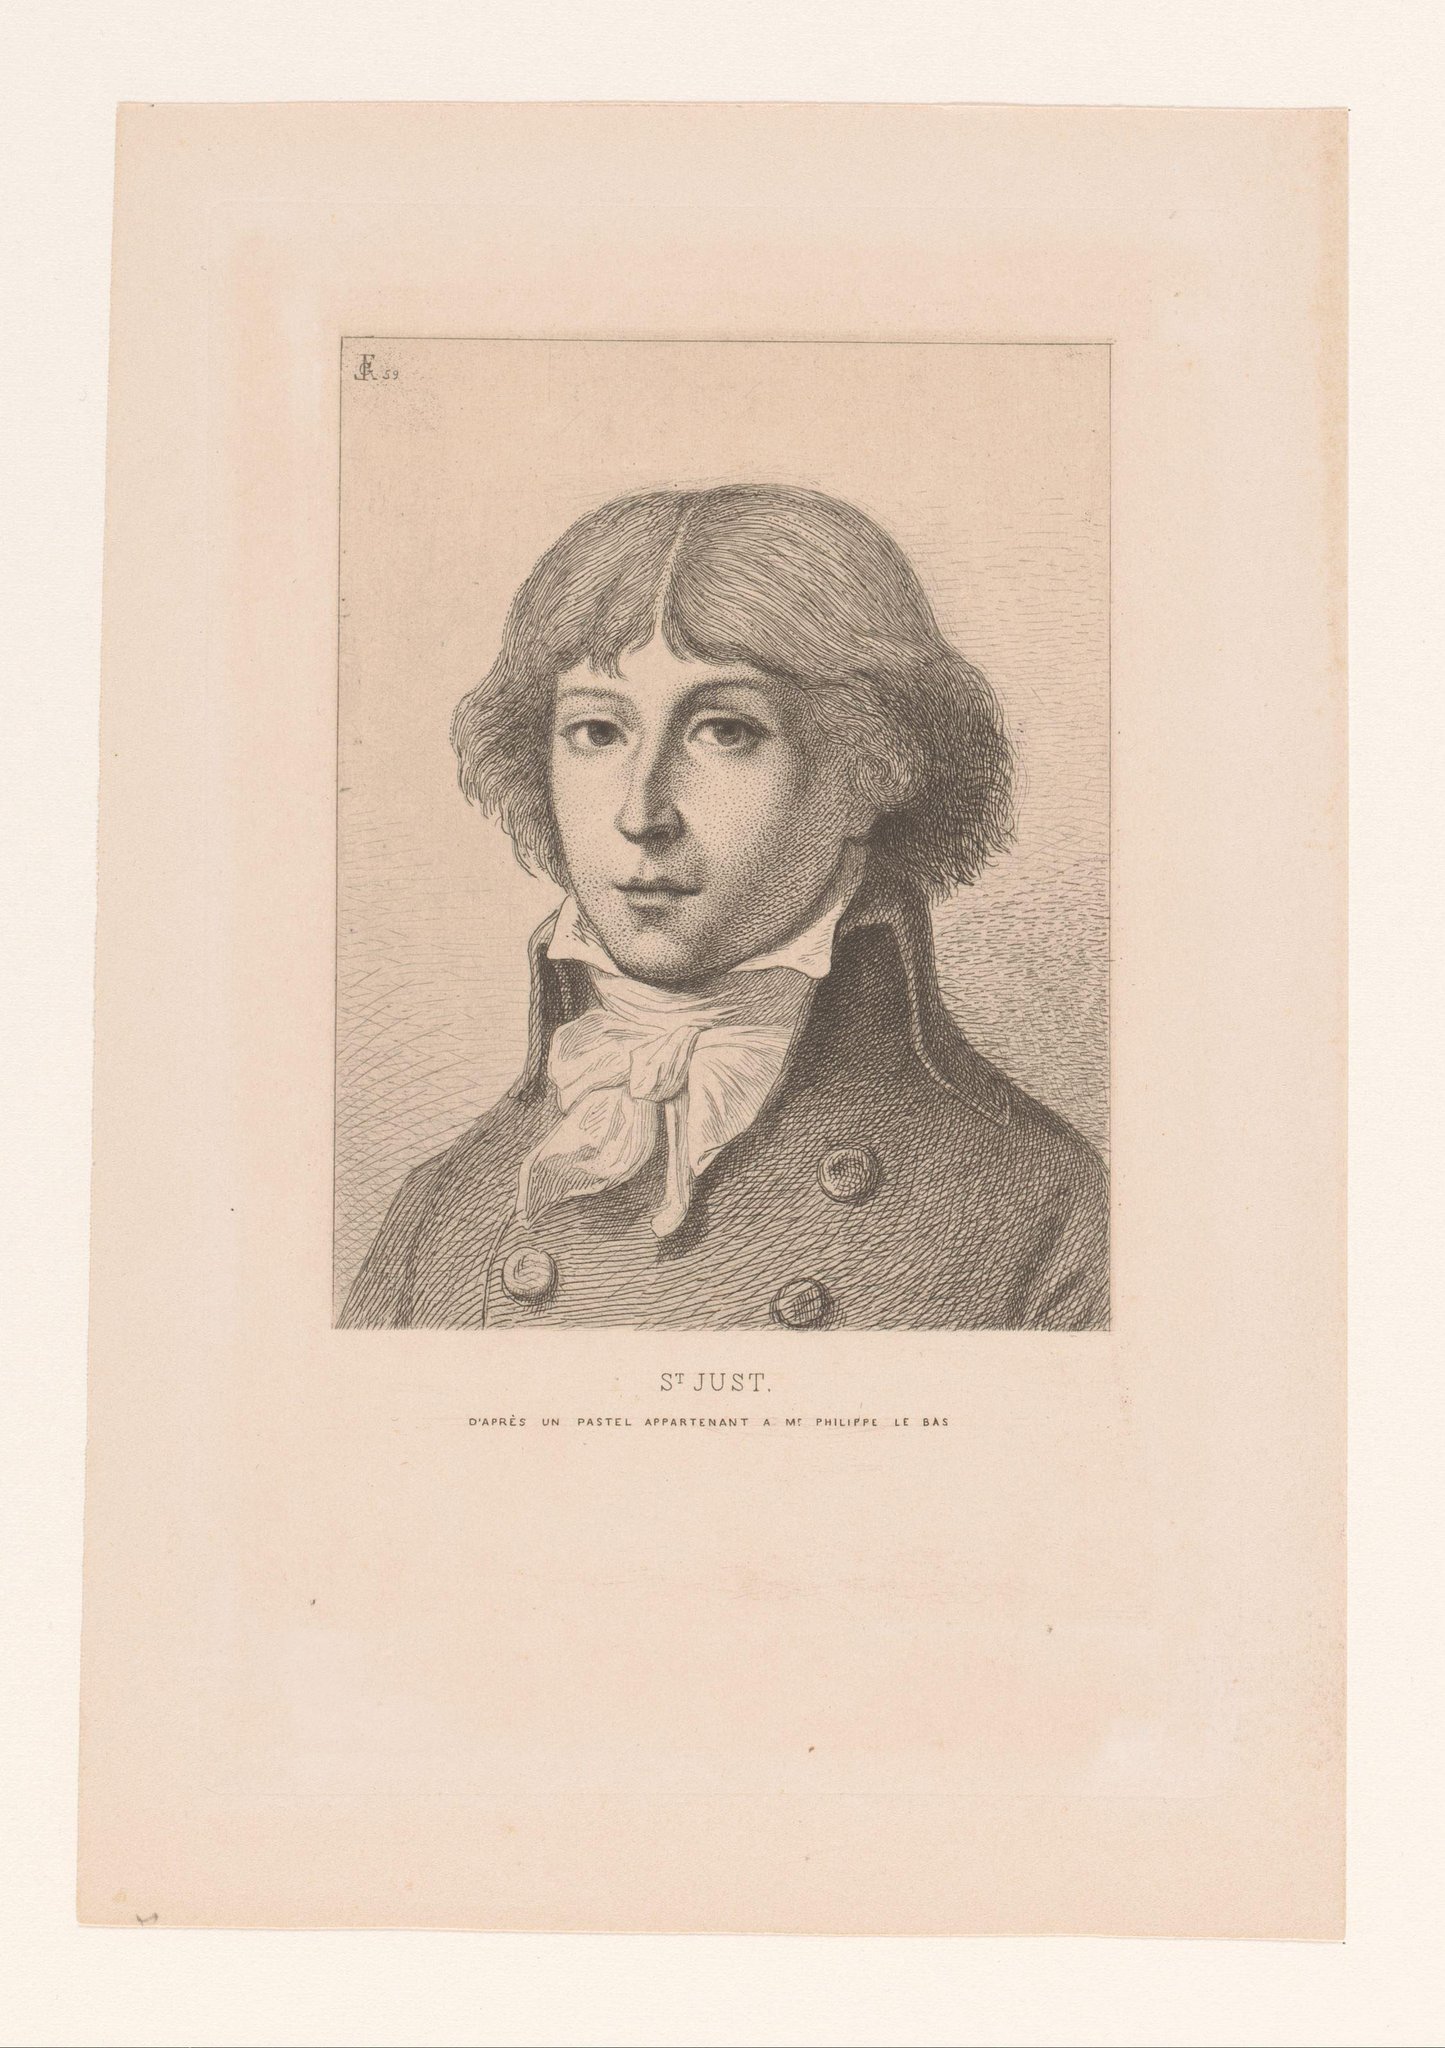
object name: print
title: Portret van Louis Antoine Leon de Saint-Just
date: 1841-1910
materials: paper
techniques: etching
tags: paris, politician, historical persons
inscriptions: collector's mark: Lugt 2228